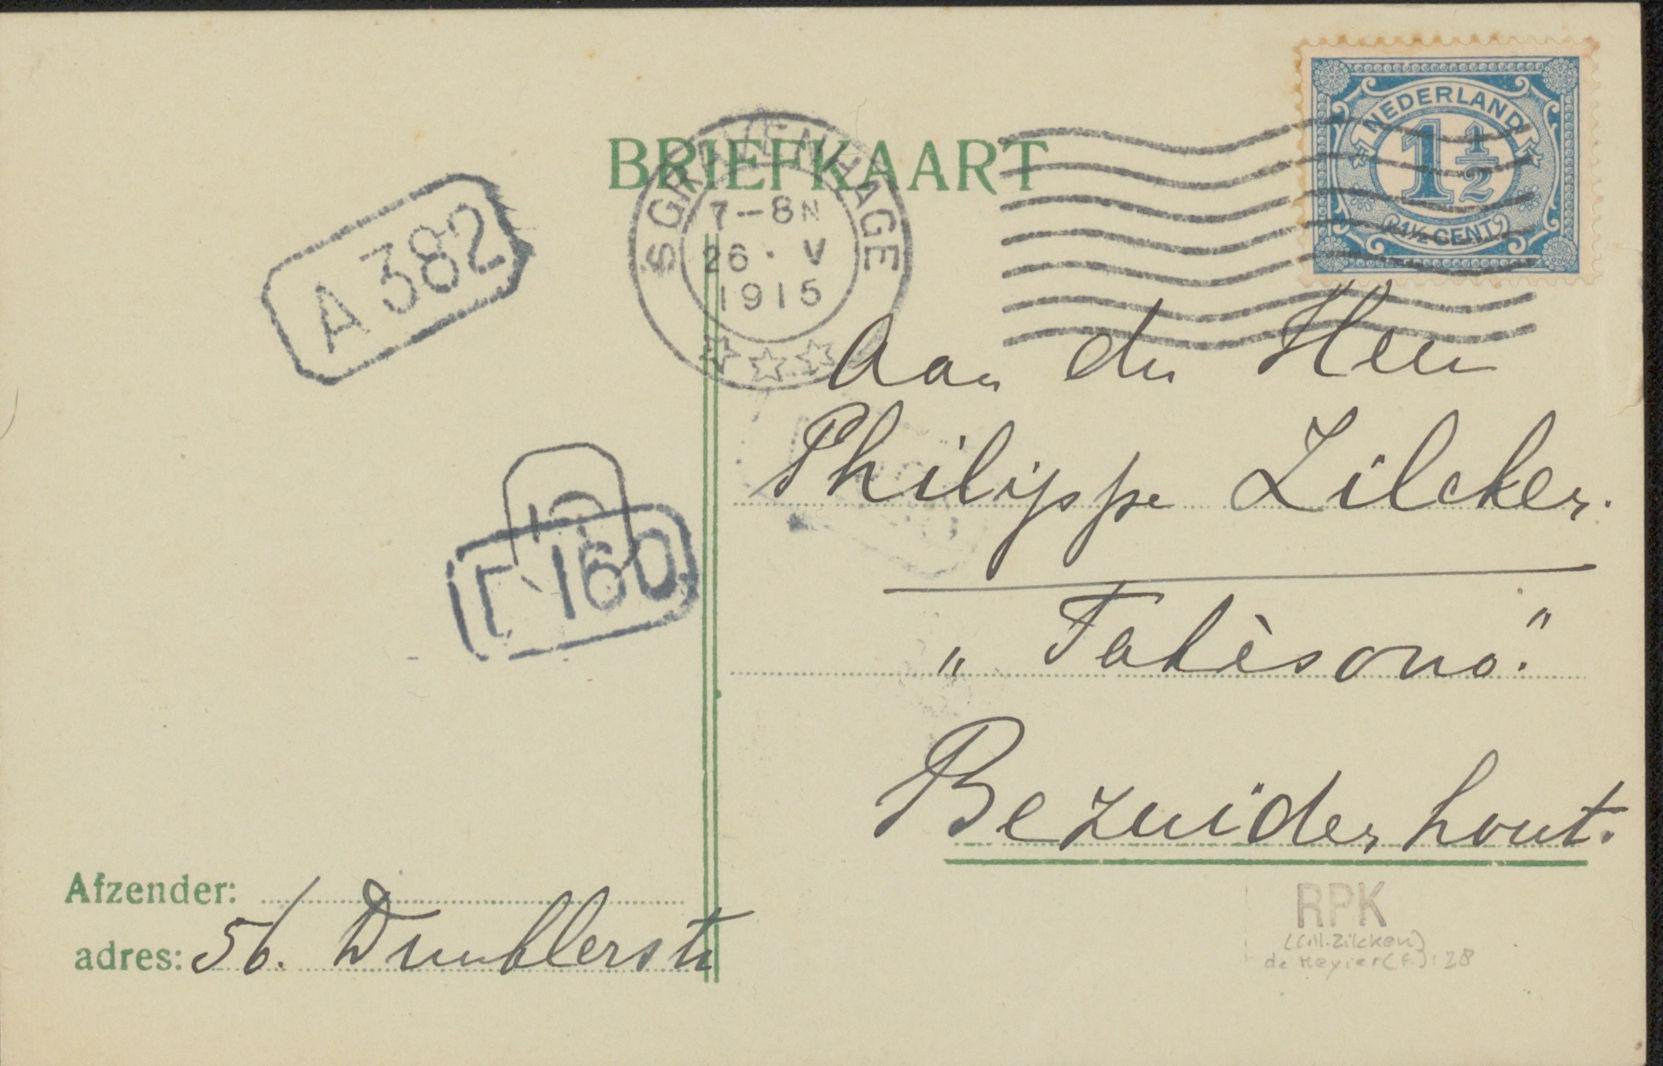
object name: postcard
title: Briefkaart aan Philip Zilcken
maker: fenna de meyier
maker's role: onderwijzer, schrijver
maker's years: 1874-1943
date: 1915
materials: cardboard, ink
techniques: pen, writing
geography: the hague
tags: louis couperus, willem byvanck, berlin, politician, fridolin marinus knobel, painter, draughtsman, philip zilcken, printed matter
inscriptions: collector's mark: ‘RPK’